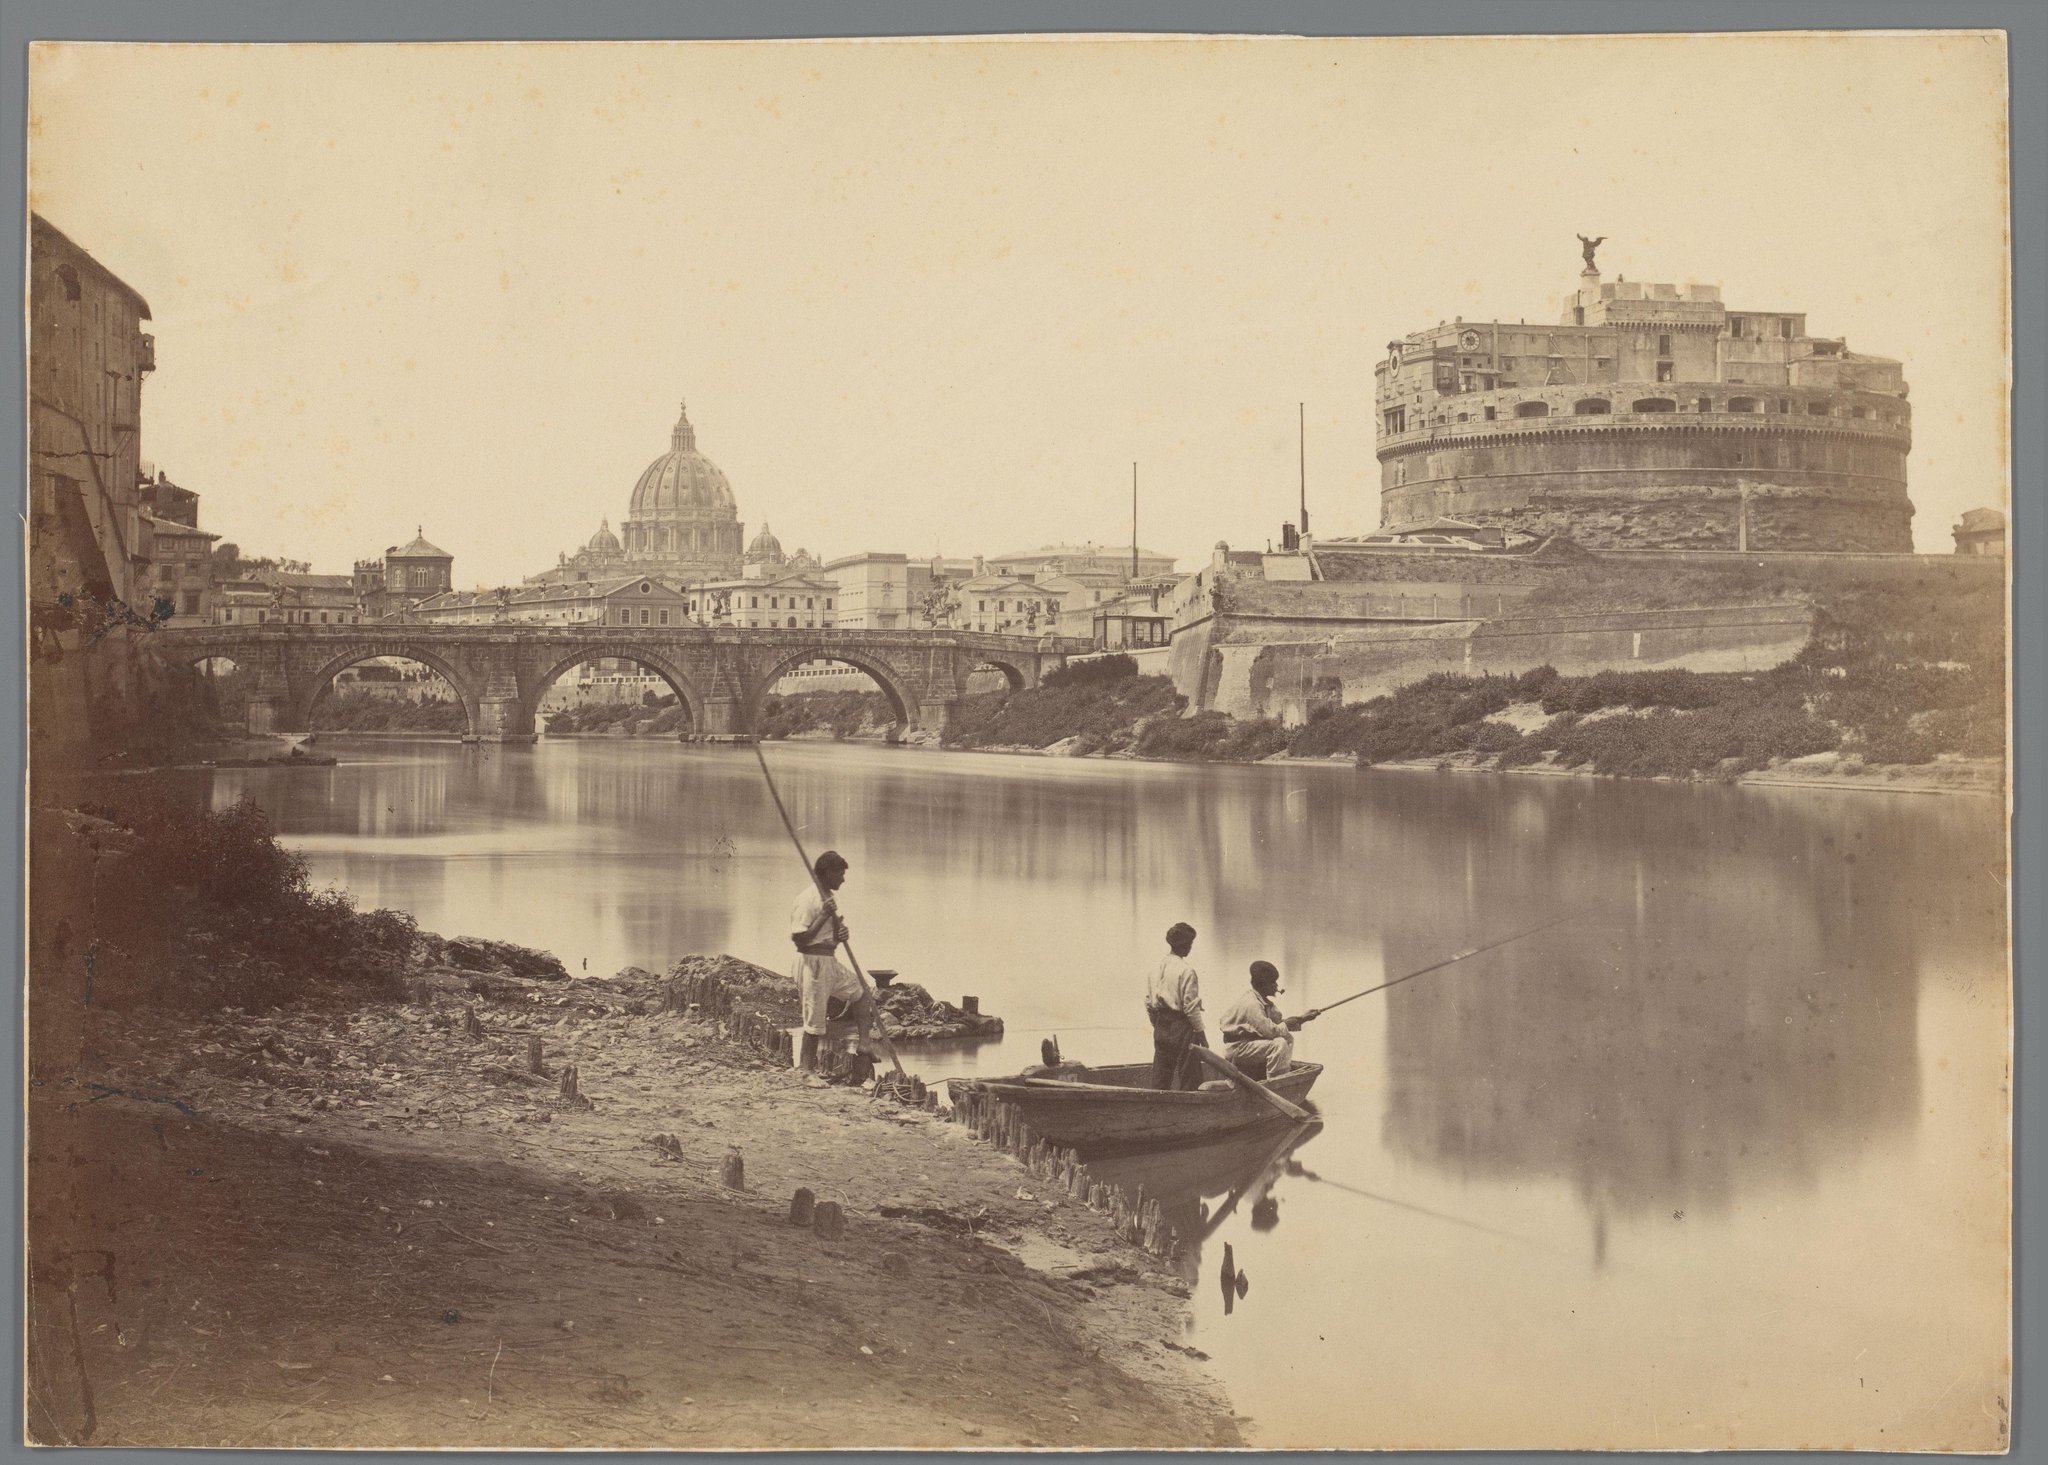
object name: photograph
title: Vissers langs de Tiber te Rome, Italië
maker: Anonymous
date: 1851-1900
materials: cardboard, paper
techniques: albumen print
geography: rome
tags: castle, river, church (exterior), bridge in city across river, canal, etc., fisherman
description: Op de achtergrond zijn de Engelenburcht, Engelenbrug en de Sint-Pietersbasiliek te zien.